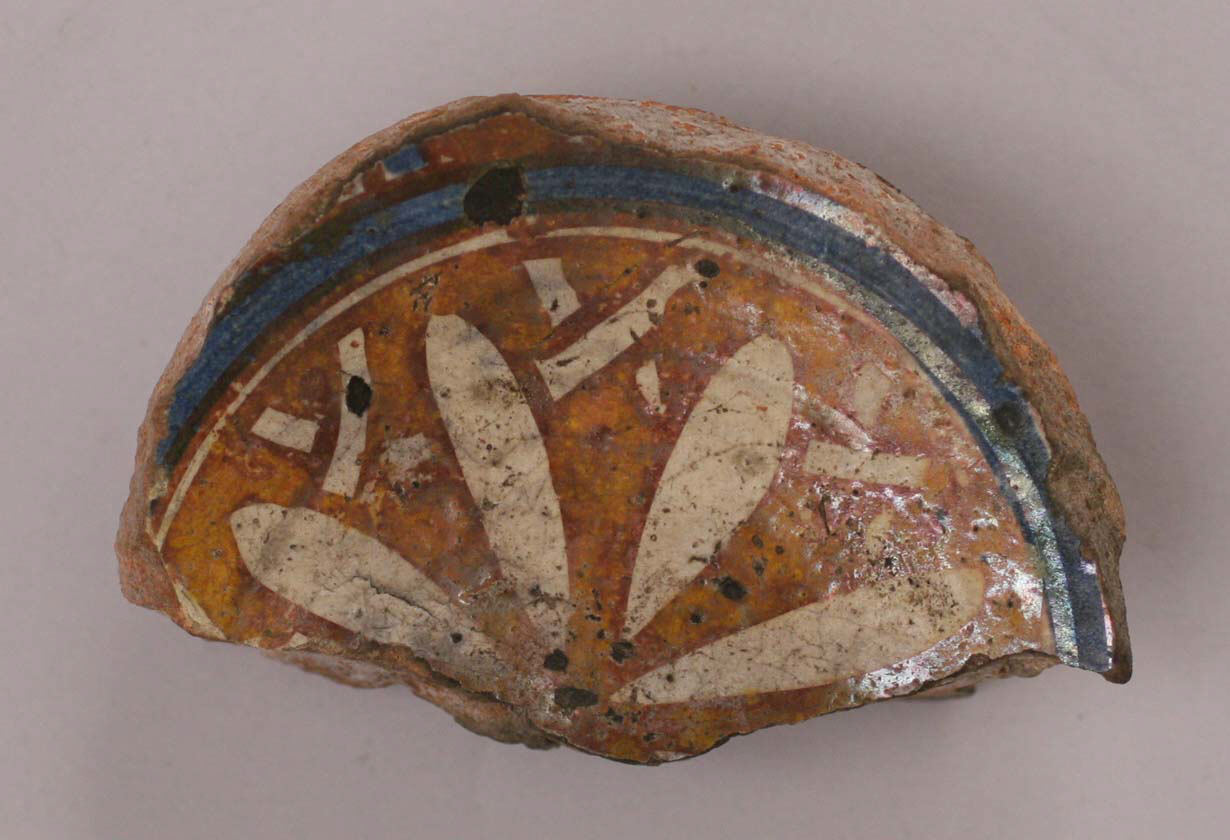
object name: fragment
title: Fragment of a Dish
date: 1401-1500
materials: earthenware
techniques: glazing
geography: spain